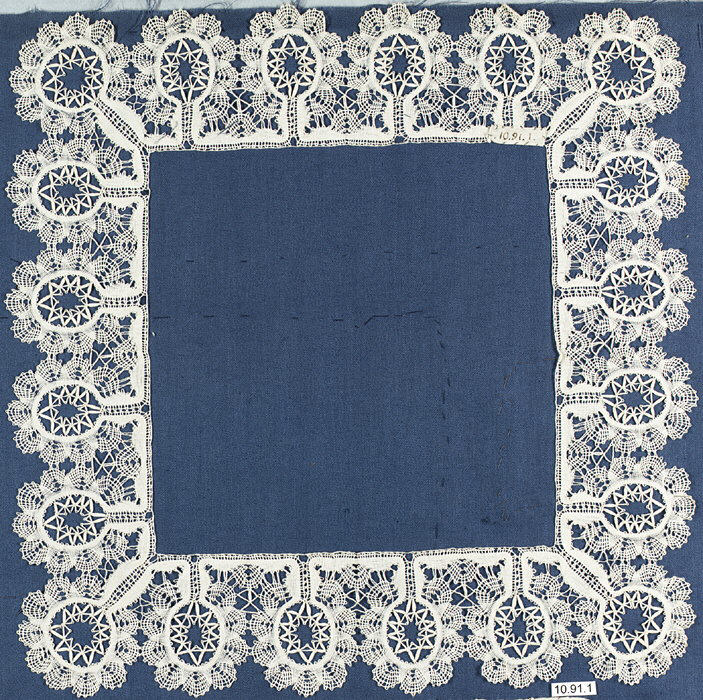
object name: handkerchief border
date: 1801-1833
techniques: lace